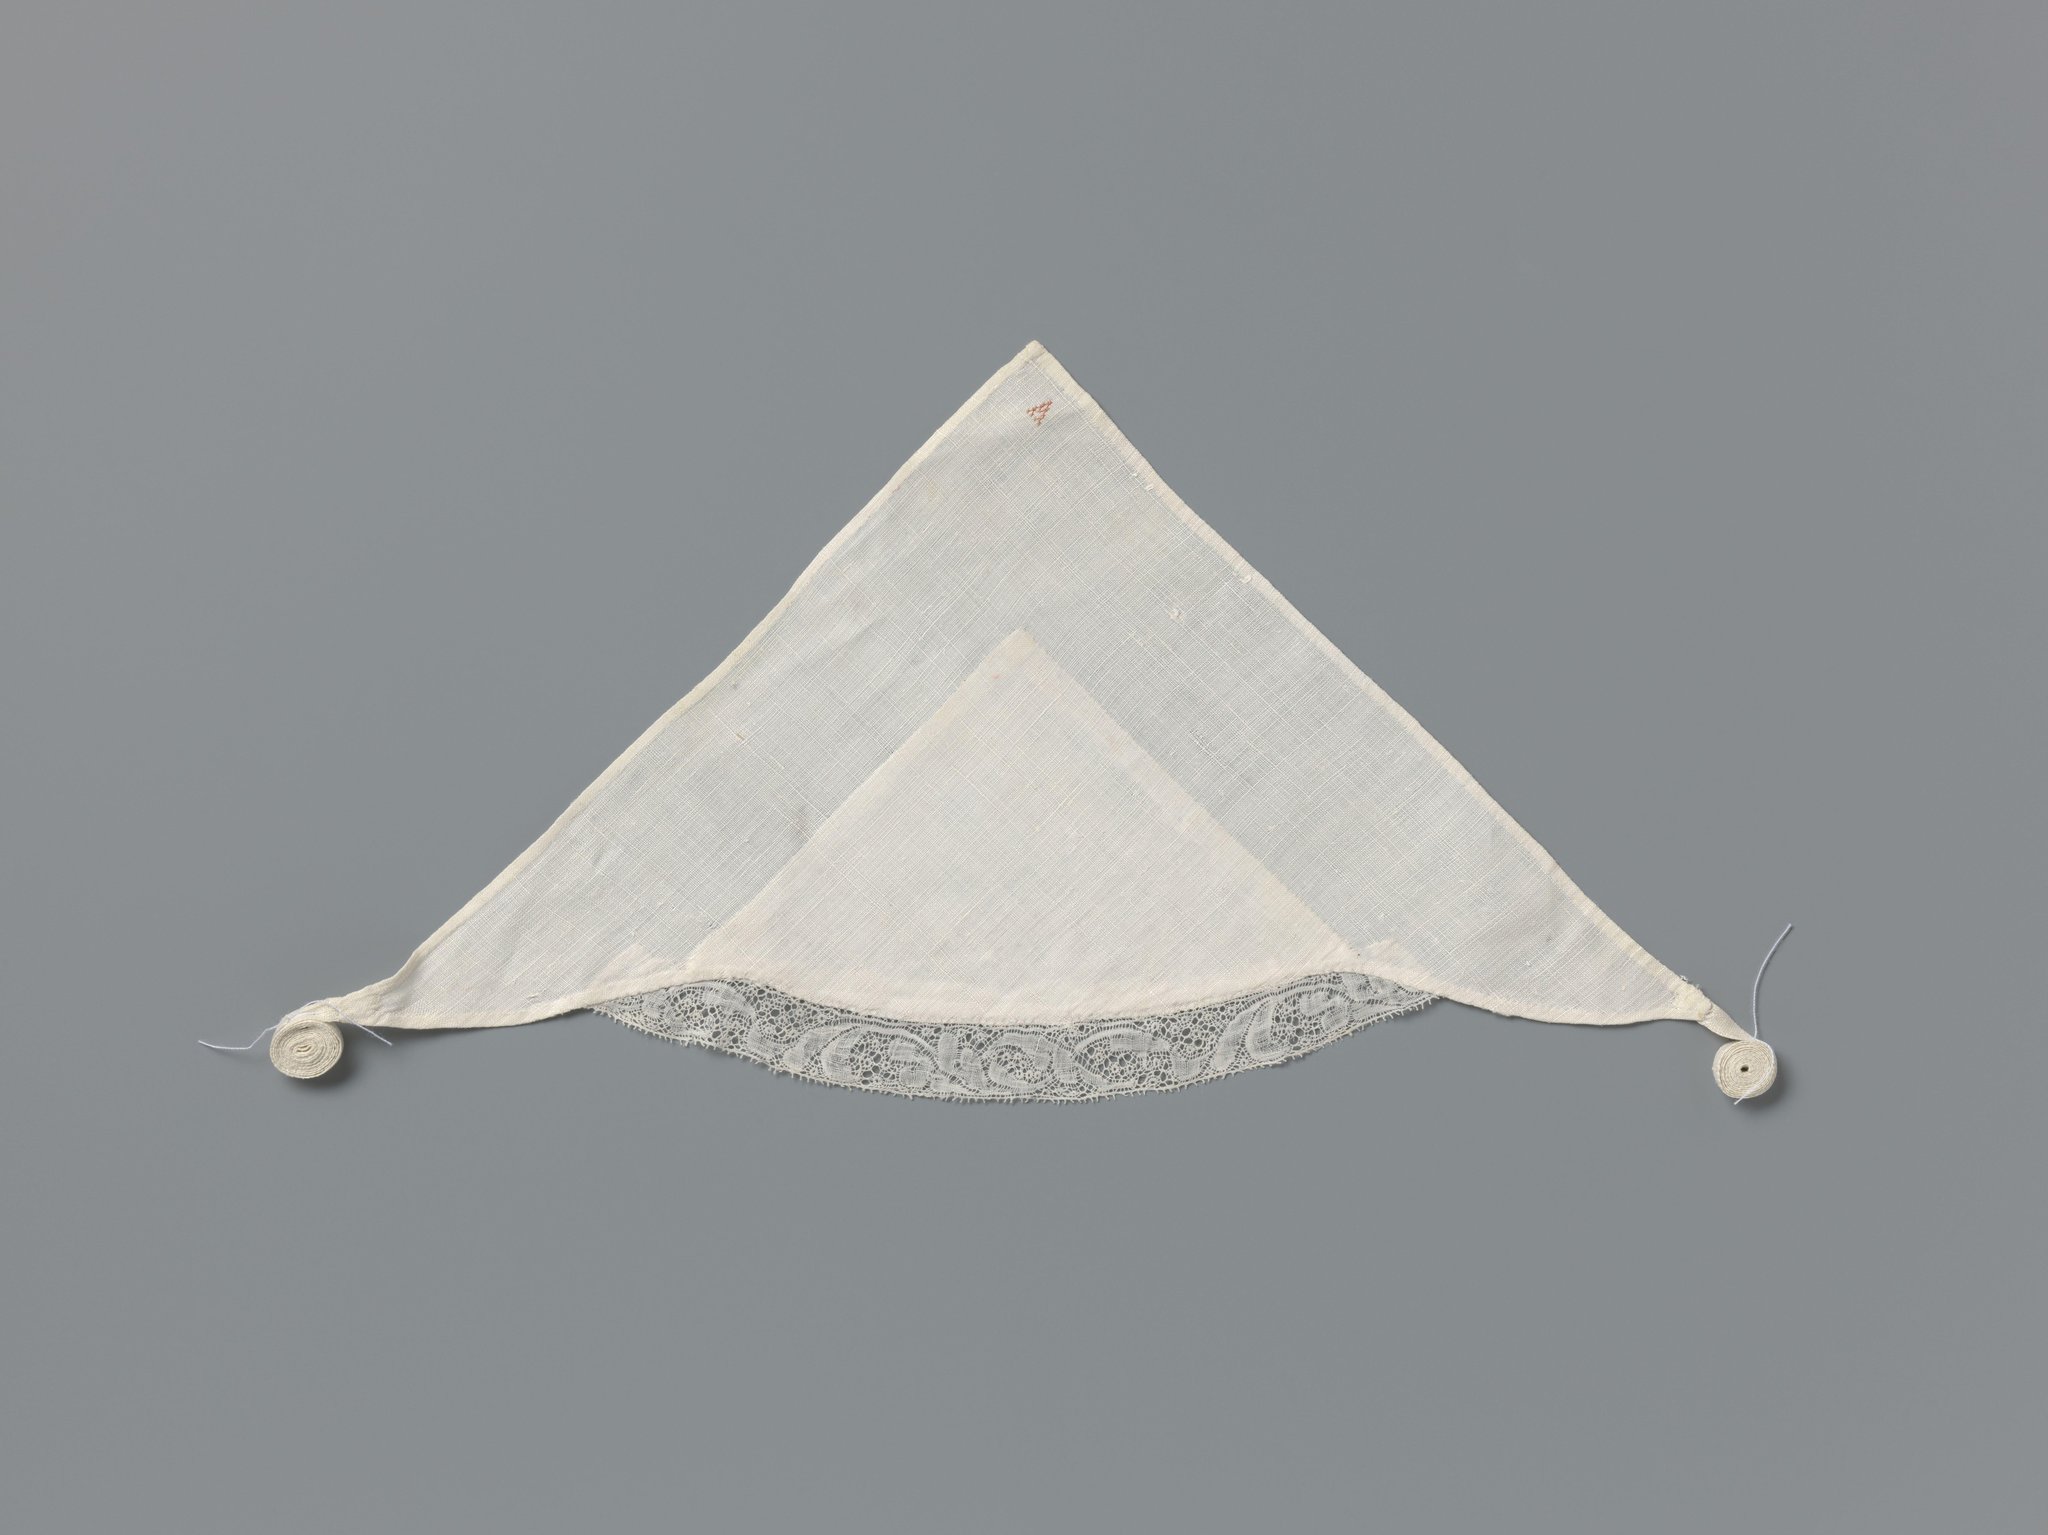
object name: childrenswear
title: Fontaneldoek van linnen met een strook Binchekant, met golvende bladrank tegen een oeil-de-perdrix fond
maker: Anonymous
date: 1700-1800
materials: linen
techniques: lace, cross stitching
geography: europe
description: Fontaneldoekje van linnen met een strook kloskant type Binche, met golvende bladrank tegen een oeil-de-perdrix fond in rode kruissteek. Merk in rode kruissteek Ay of A9.